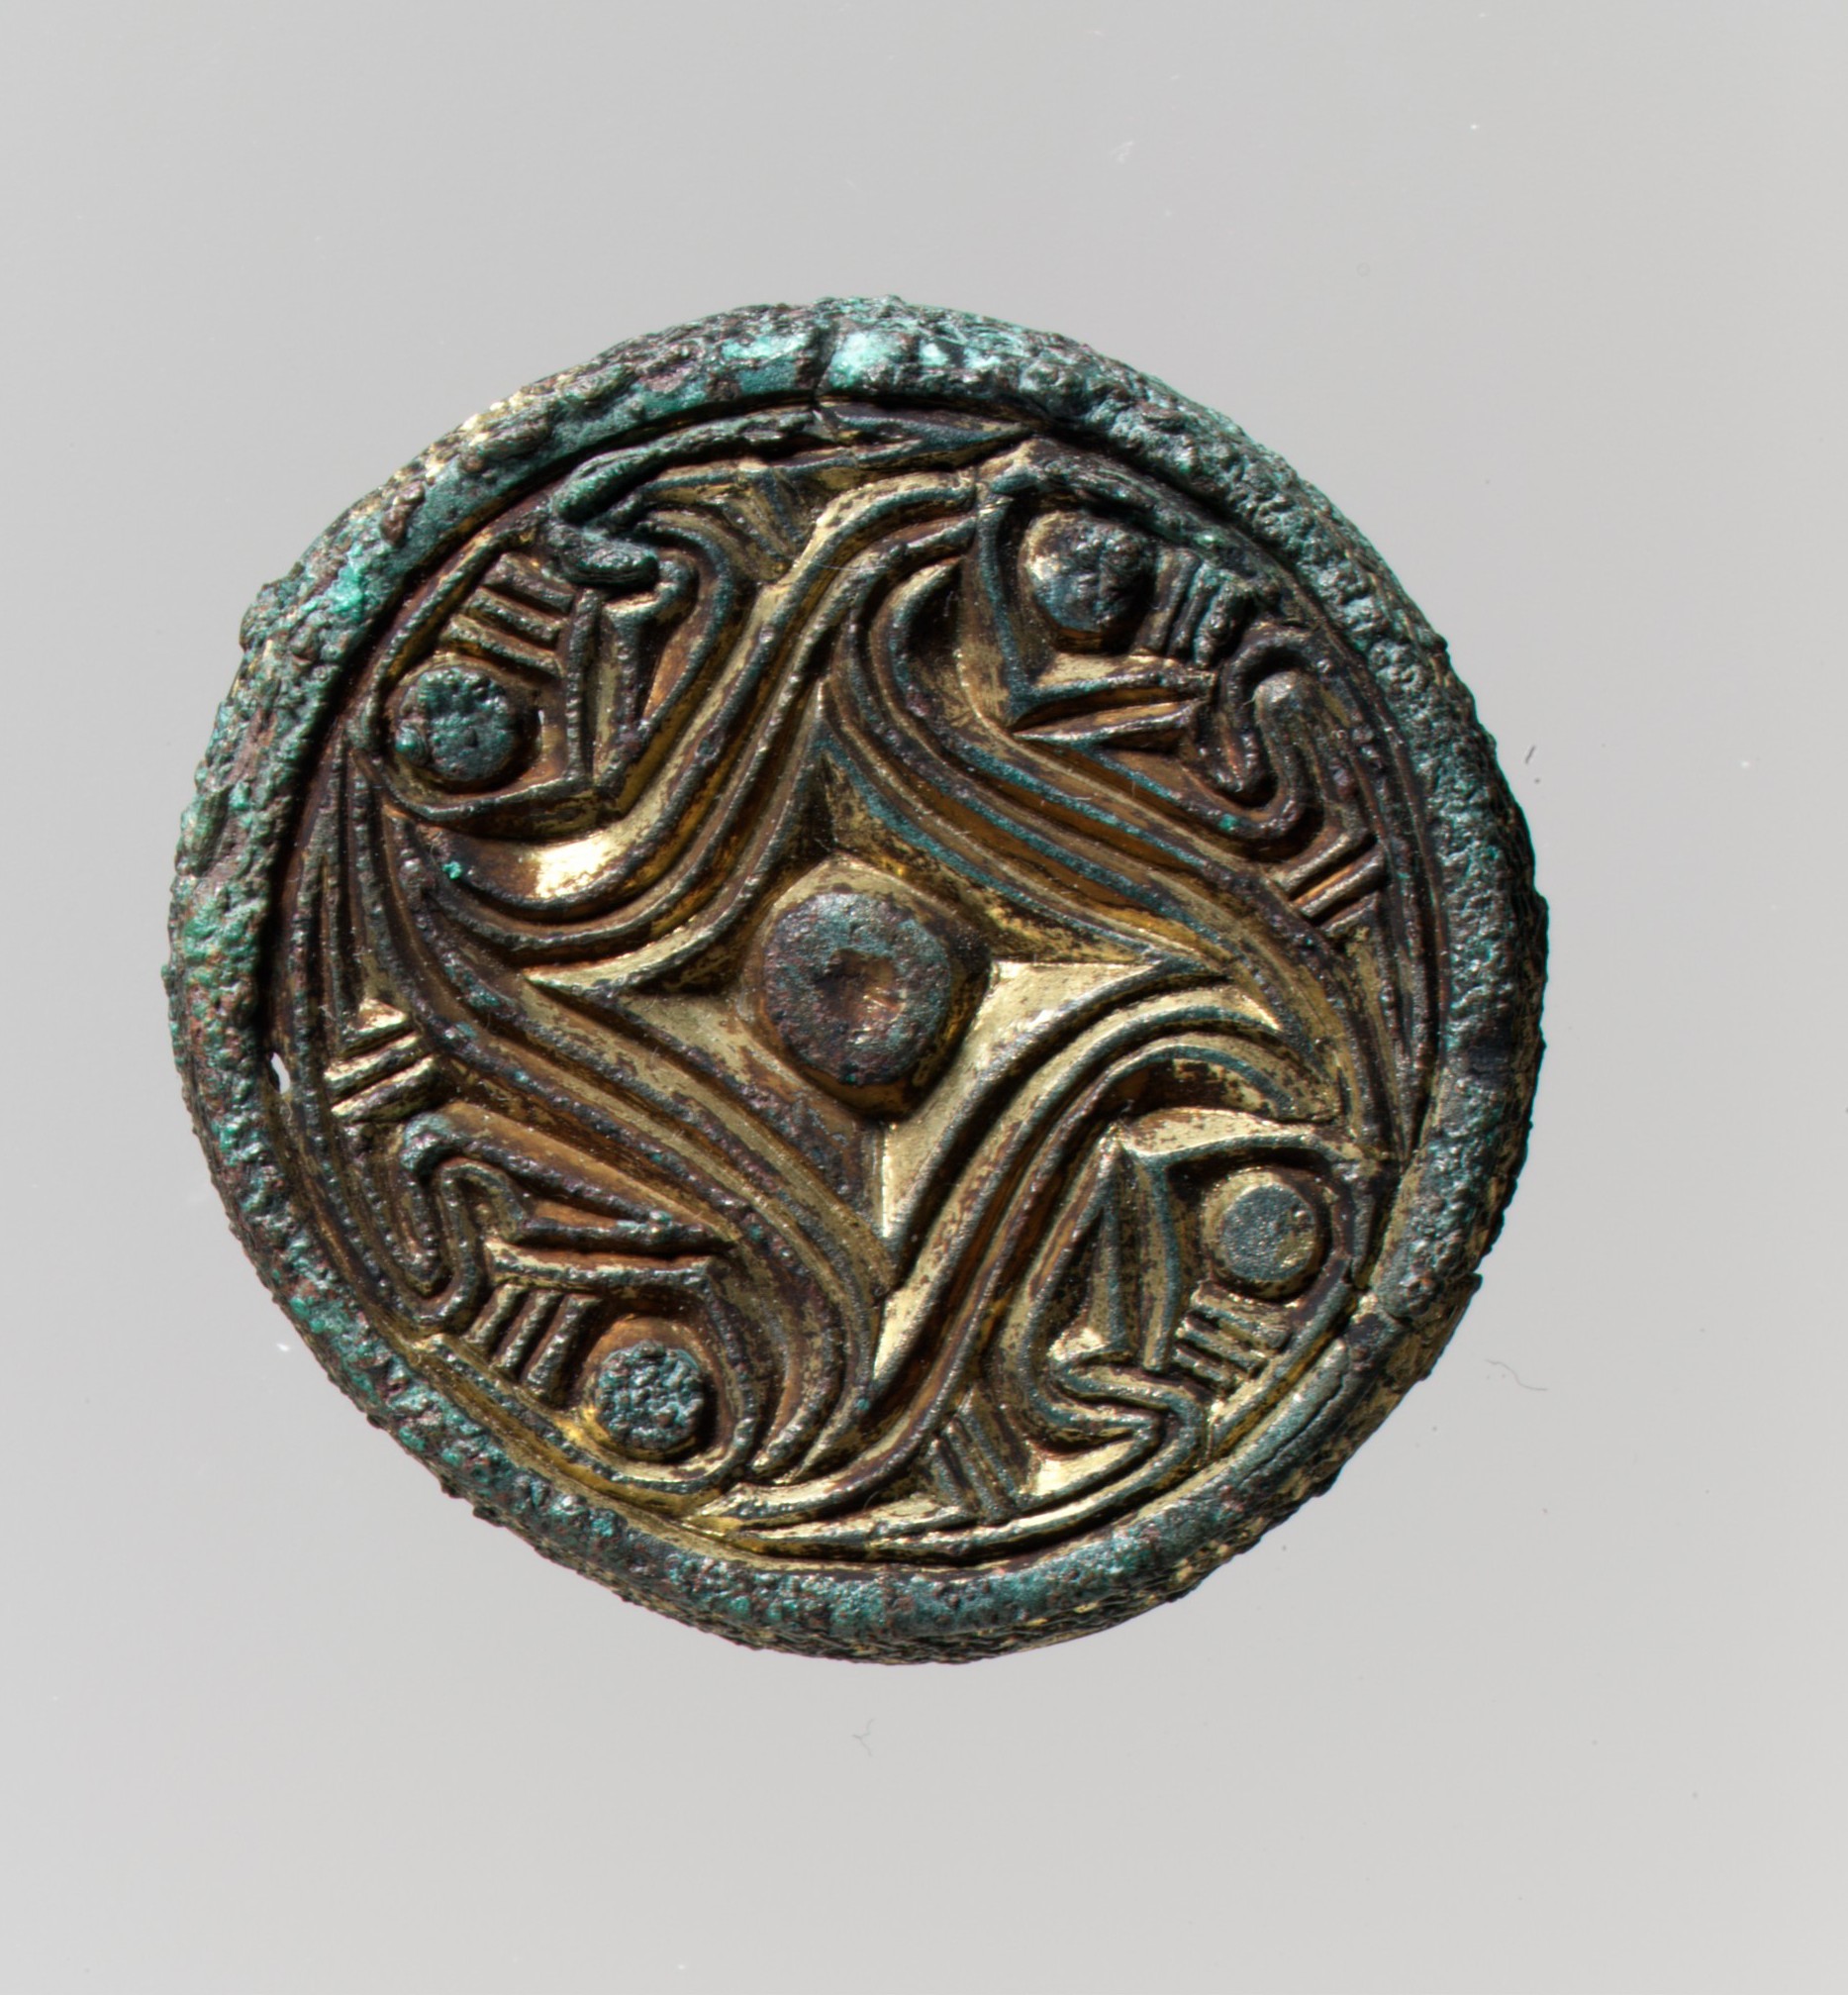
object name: brooch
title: Disk Brooch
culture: vendel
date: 600-650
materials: copper alloy, gilt